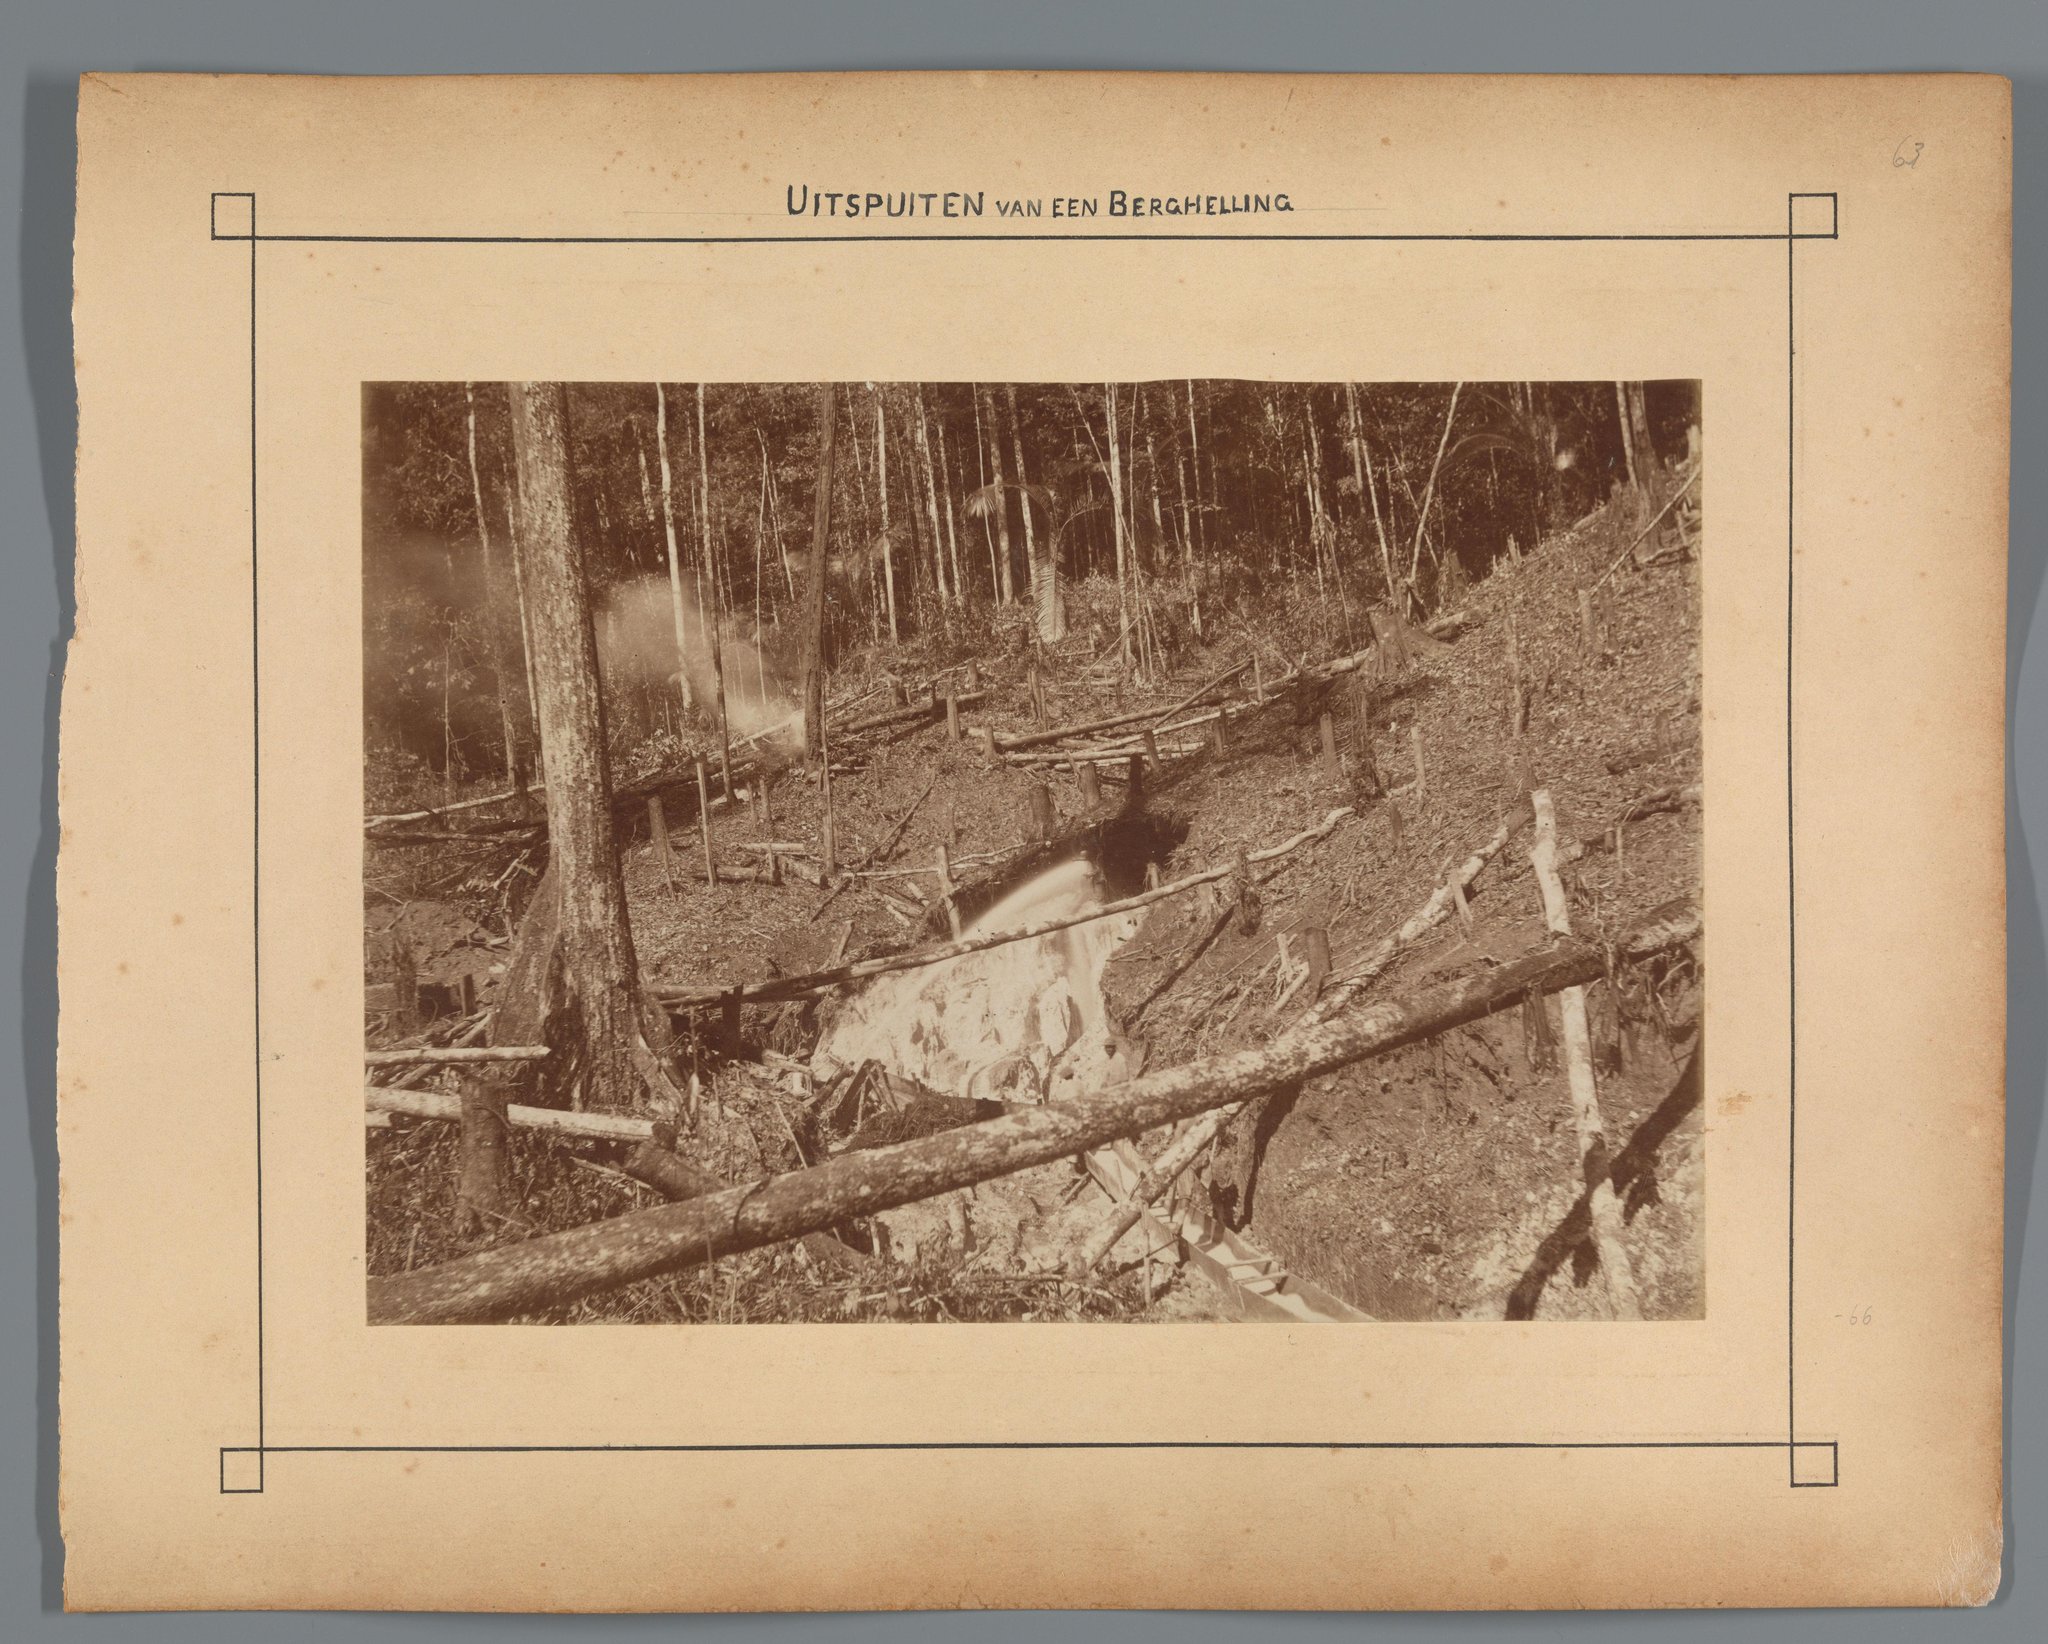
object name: photograph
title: Uitspuiten van een berghelling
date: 1898-1902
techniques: albumen print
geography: suriname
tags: opencast mine; strip mining, suriname